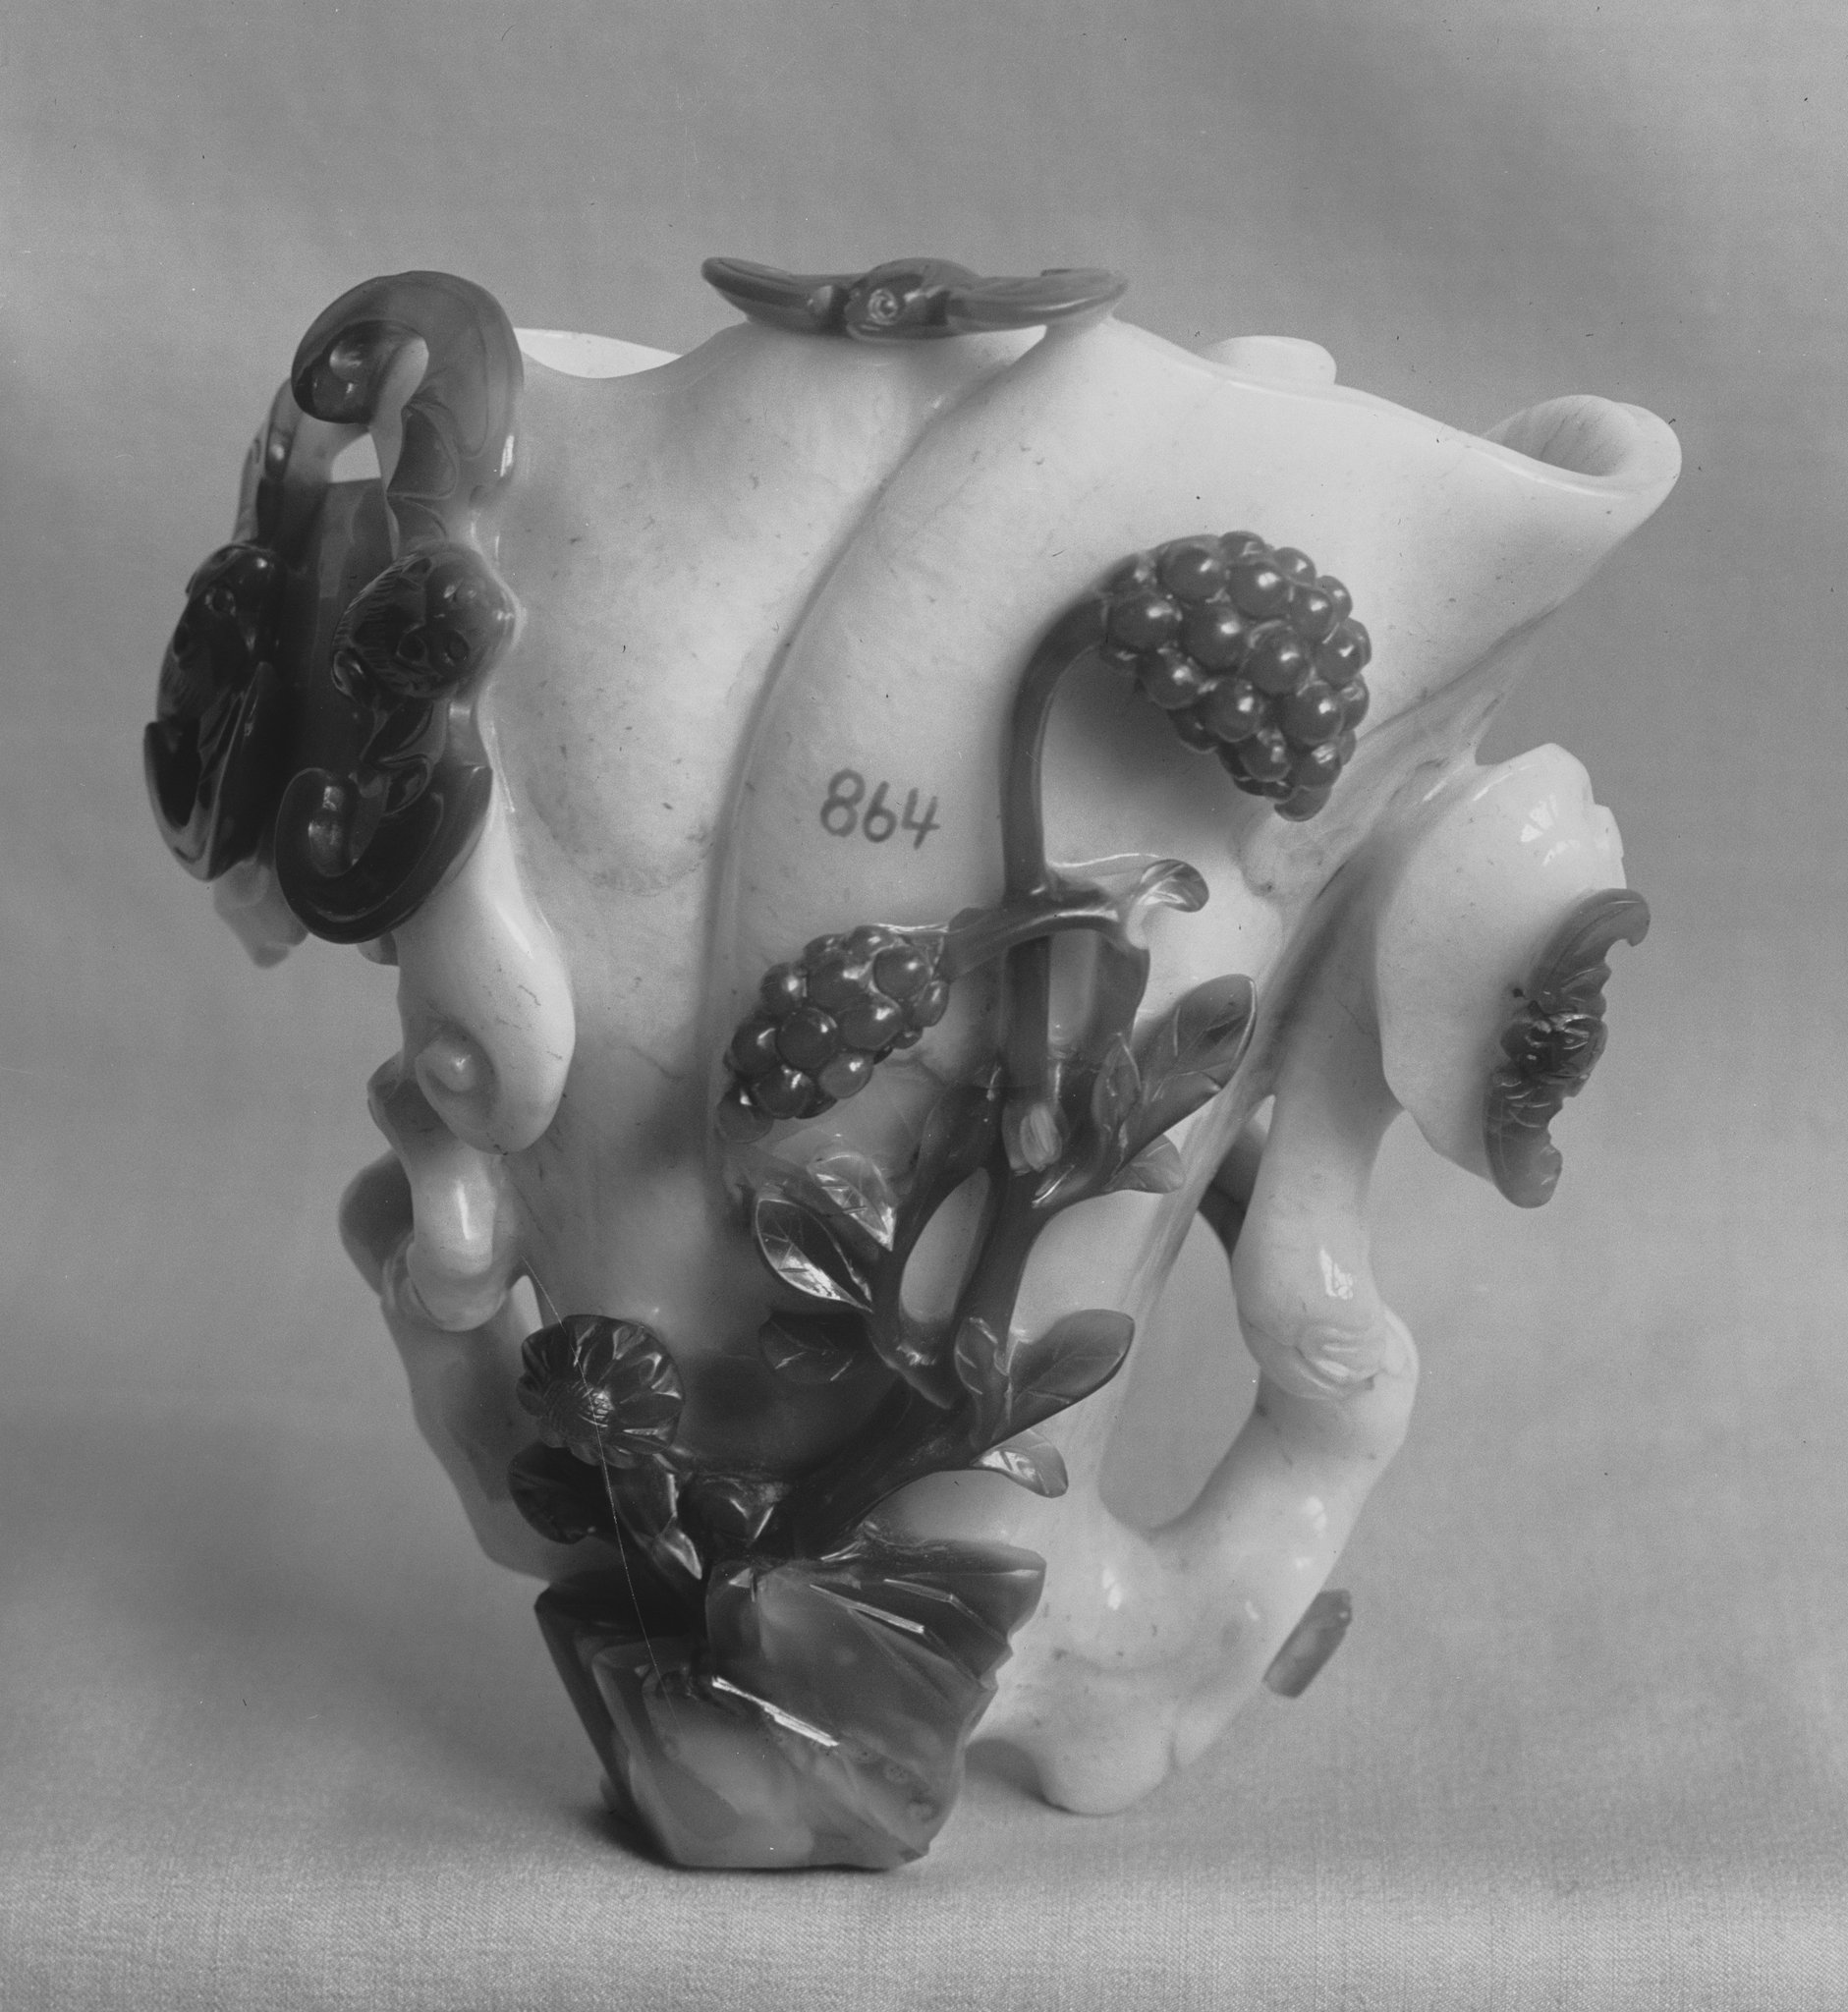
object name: vase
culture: chinese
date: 1701-1800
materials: stone, gemstone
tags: grapes,leaves